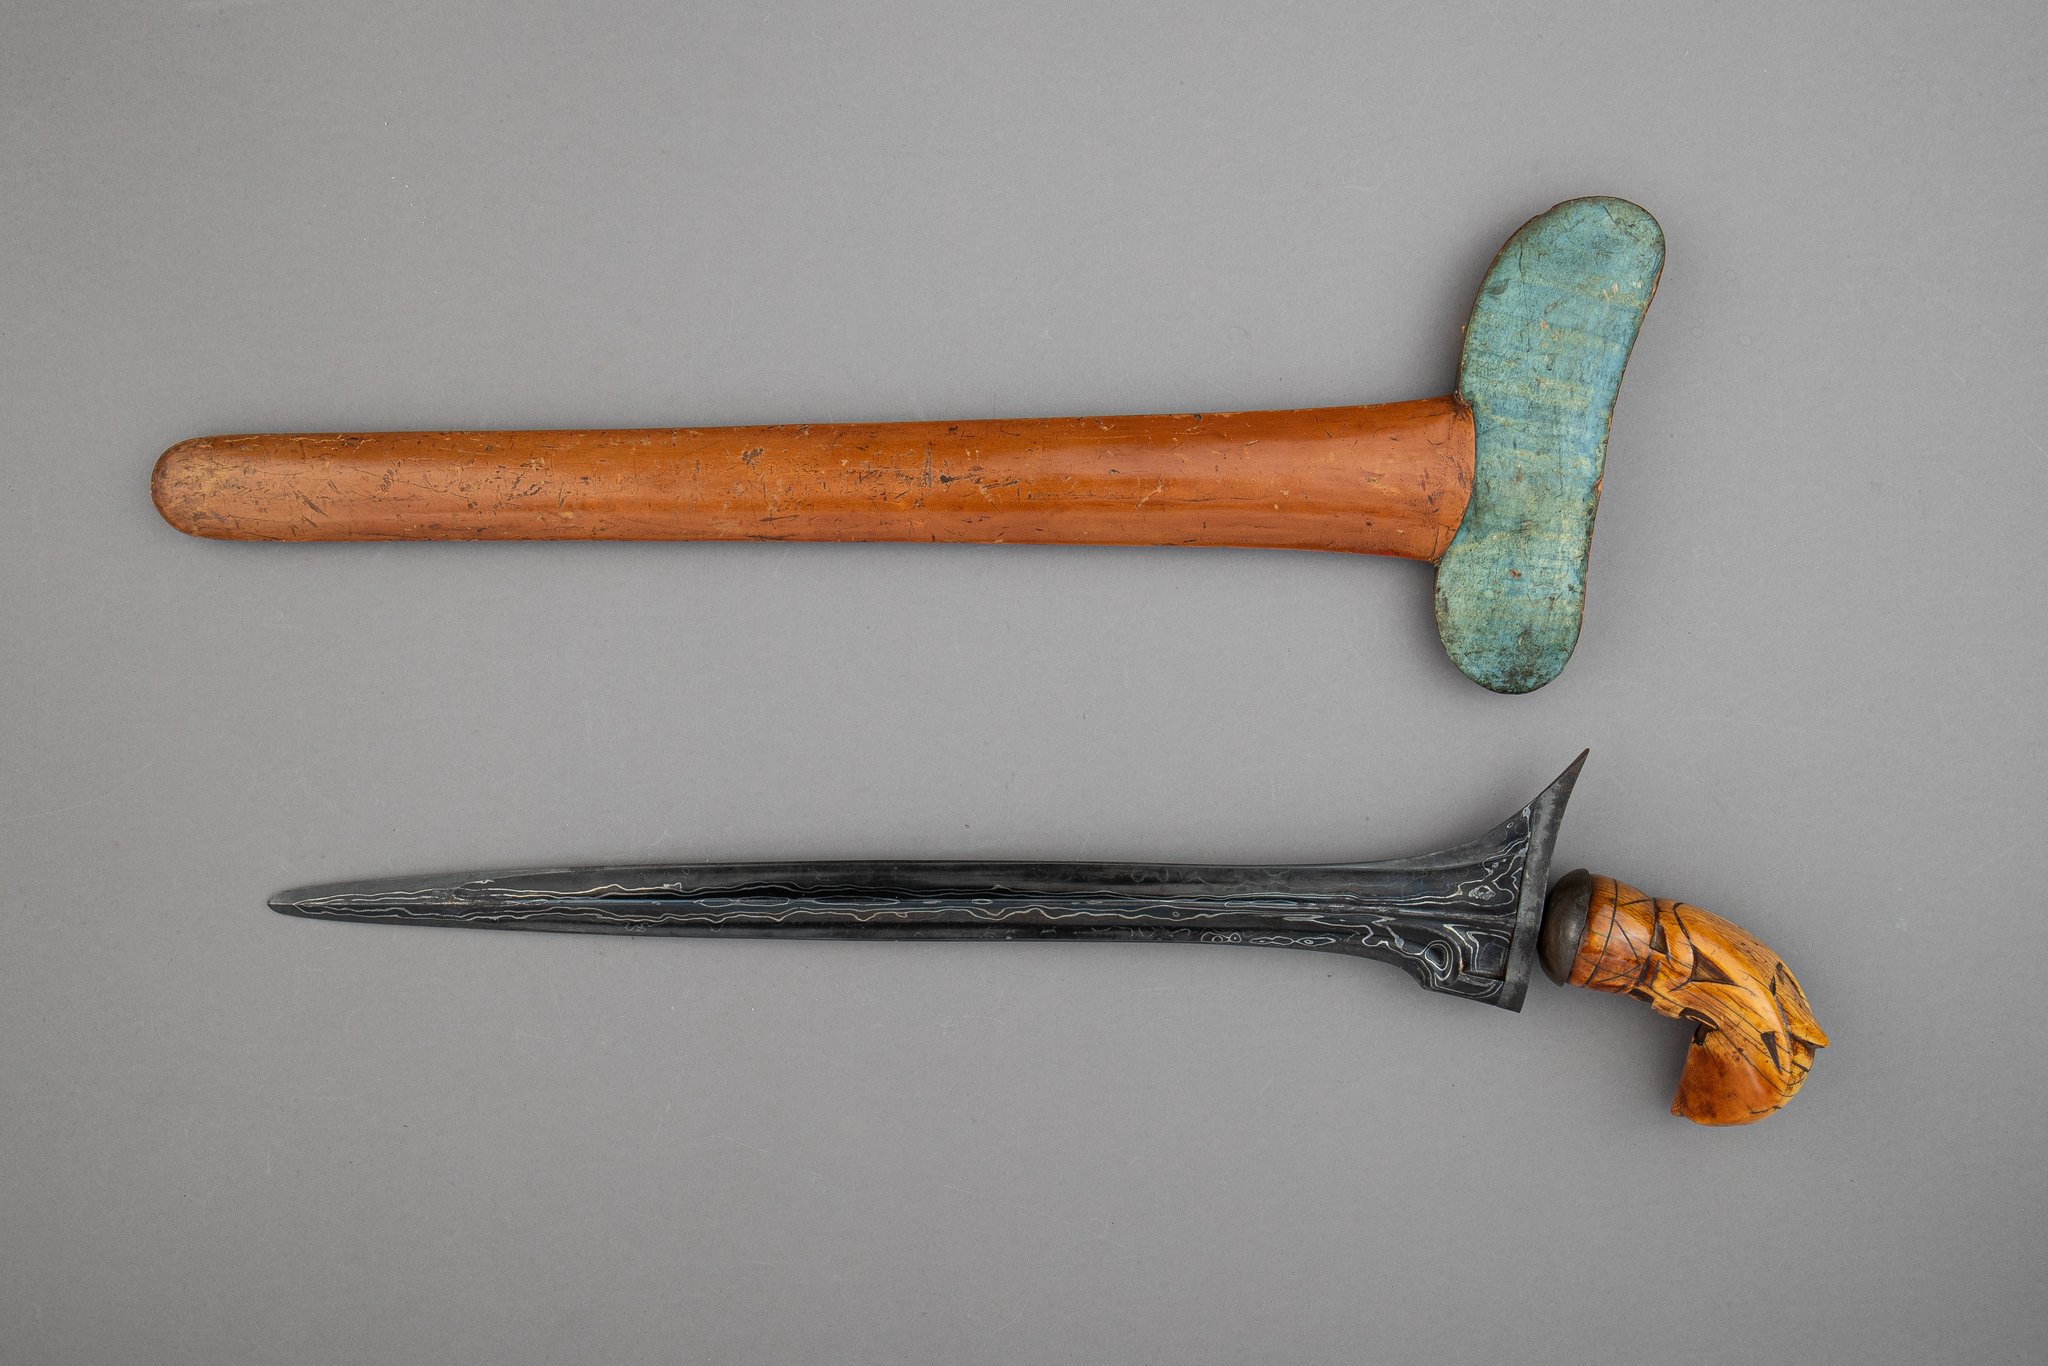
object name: kris with sheath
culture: balinese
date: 1501-1900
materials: ivory, pigment, steel, wood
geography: indonesia